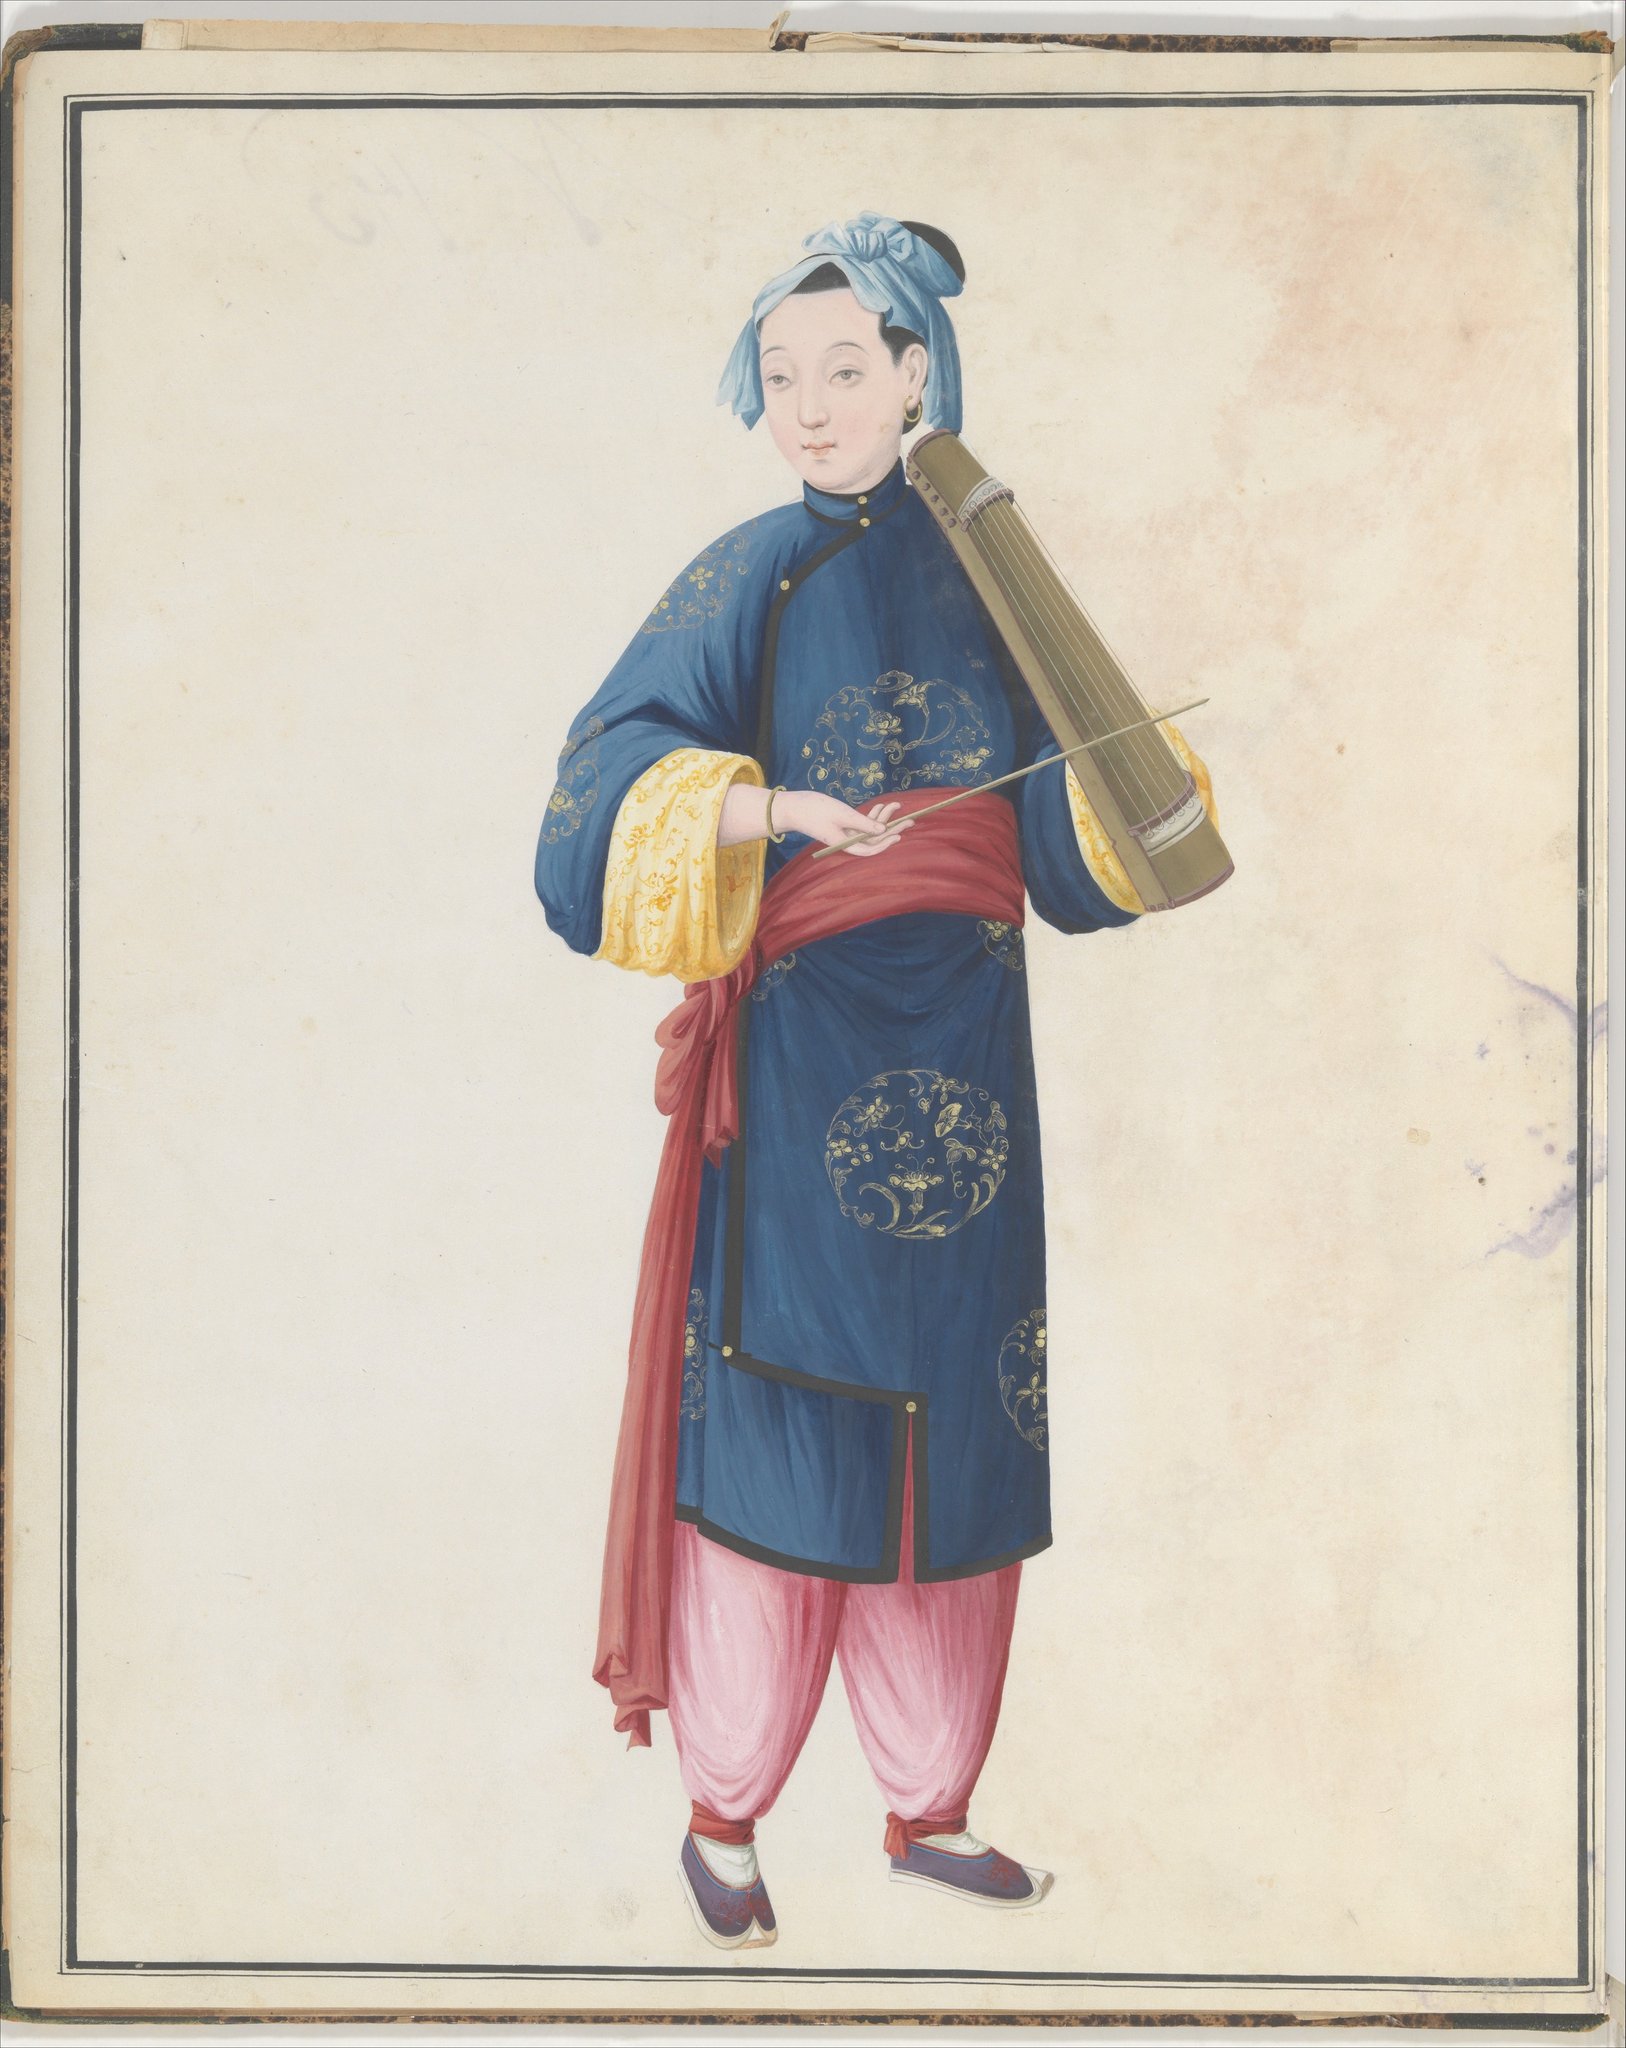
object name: watercolor of musician playing a yazheng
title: Watercolor of musician playing yazheng with rosened bow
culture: chinese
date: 1767-1800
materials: paper, watercolor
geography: china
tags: musical instruments,women,musicians